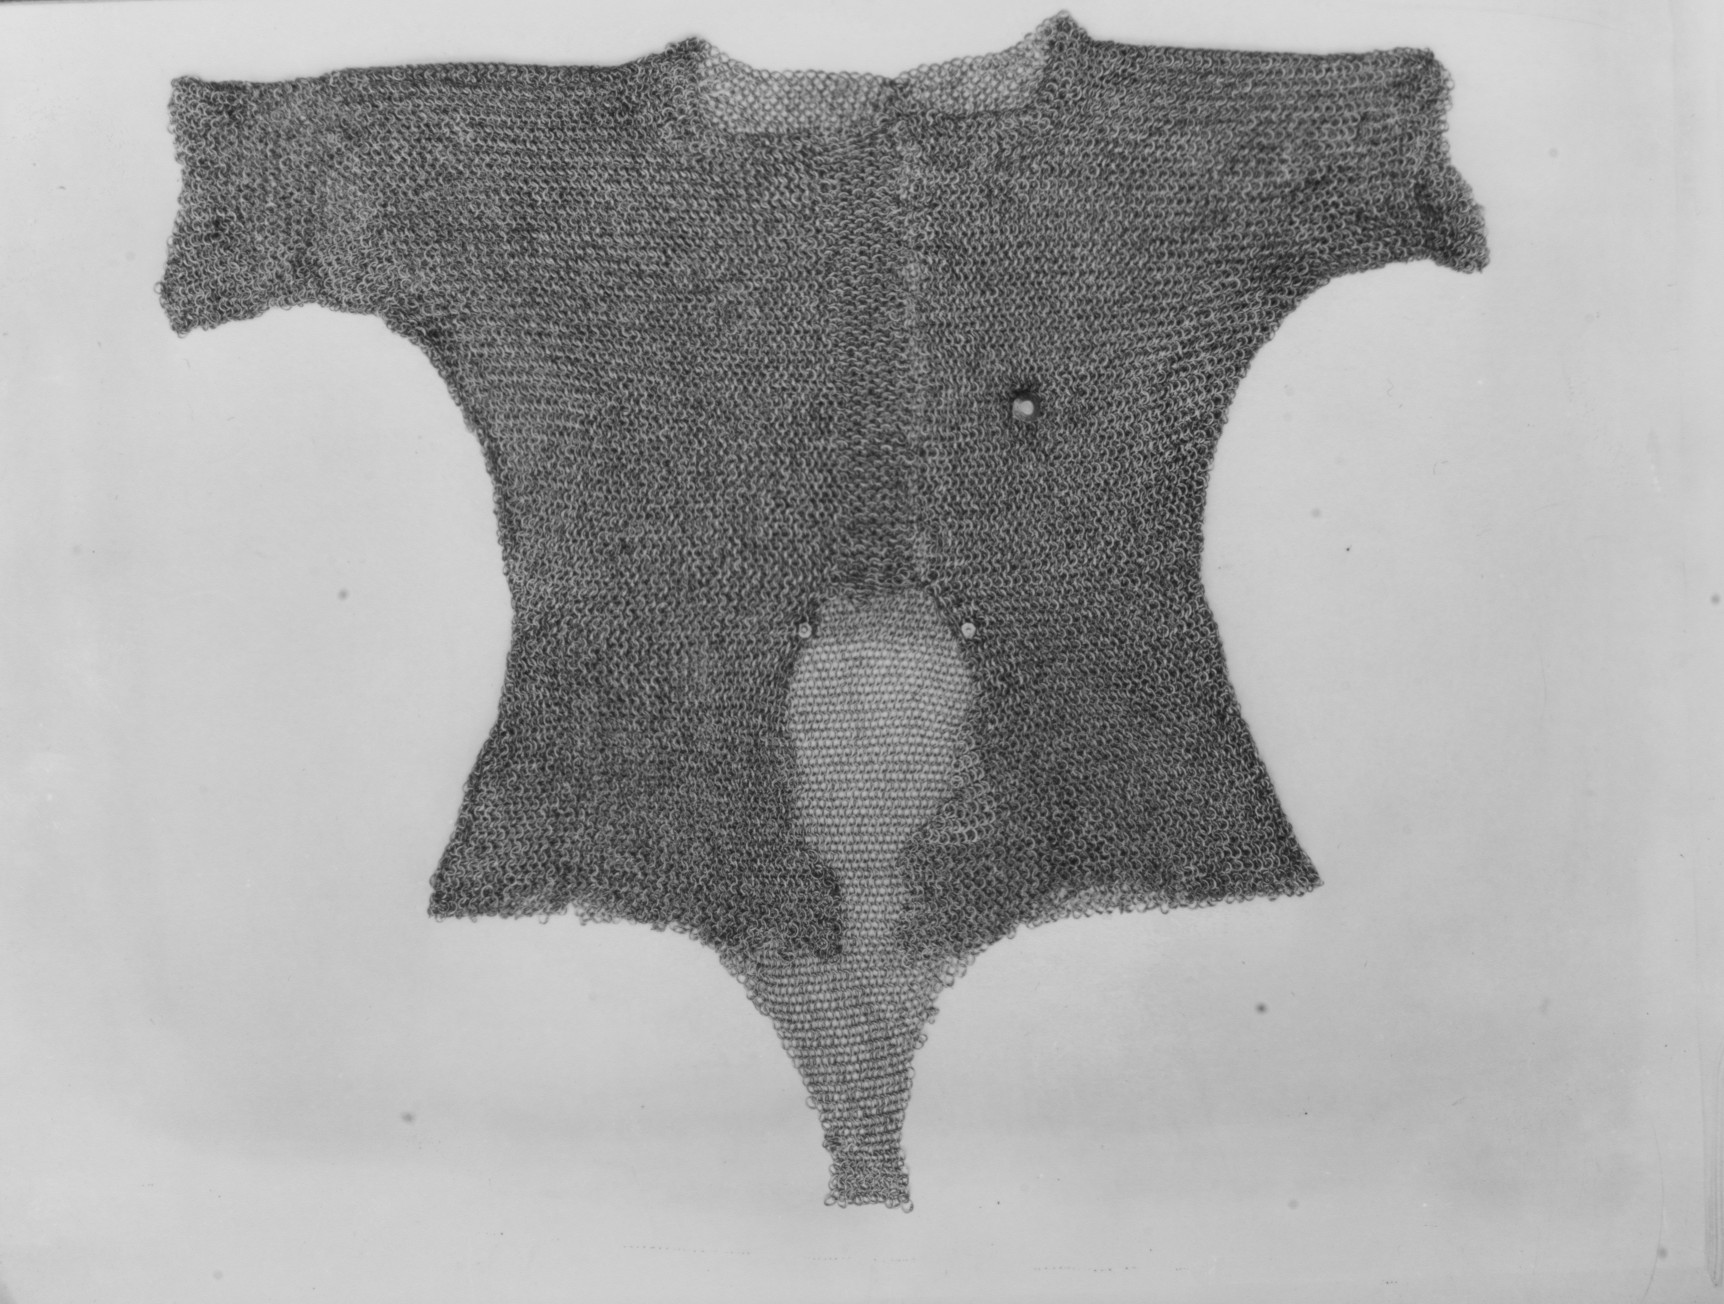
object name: hauberk of mail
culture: german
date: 1401-1500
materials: bronze, copper alloy, iron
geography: germany